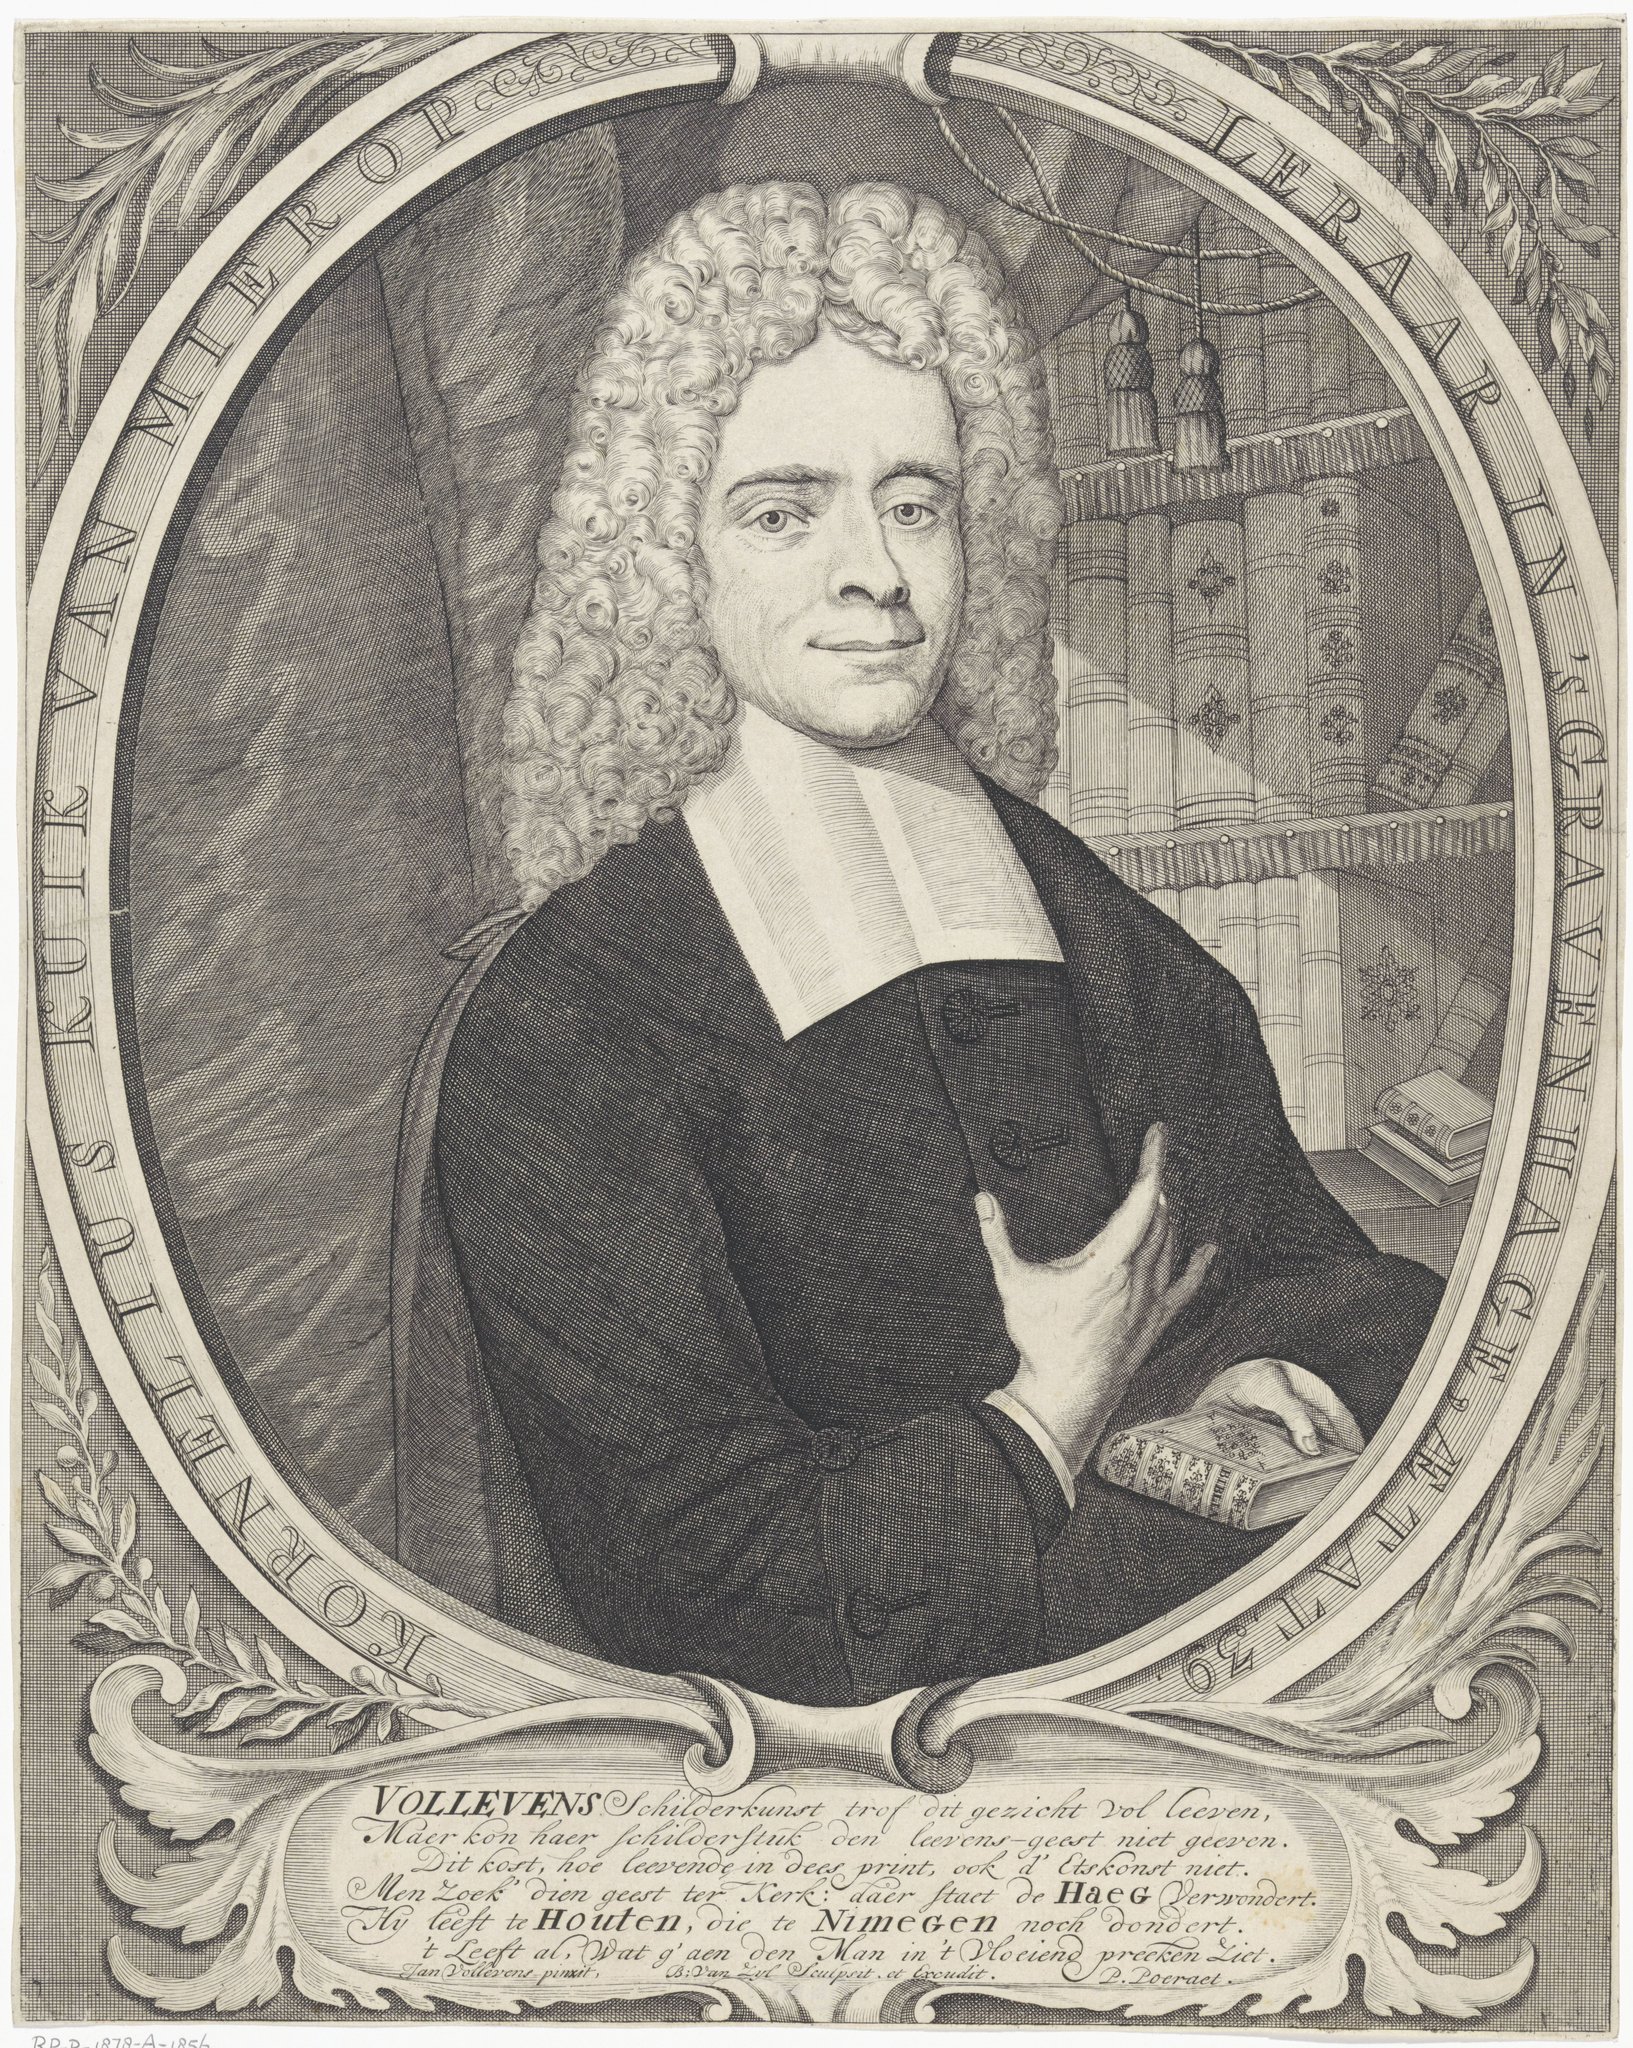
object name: print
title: Portret van Kornelius Kuik van Mierop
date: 1709-1718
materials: paper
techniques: engraving, etching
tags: utrecht, the hague, bookcase, with doors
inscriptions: collector's mark: Lugt 2228, inscription: ‘geboore te Utrecht’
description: Portret van de Haagse predikant Kornelius Kuik van Mierop op 39-jarige leeftijd. Hij houdt een Bijbel in klein formaat in de hand. Achter hem een boekenkast. Rondom het portret zijn naam, functie en leeftijd, omkranst door lauwertakken. Onder het portret een lofdicht.